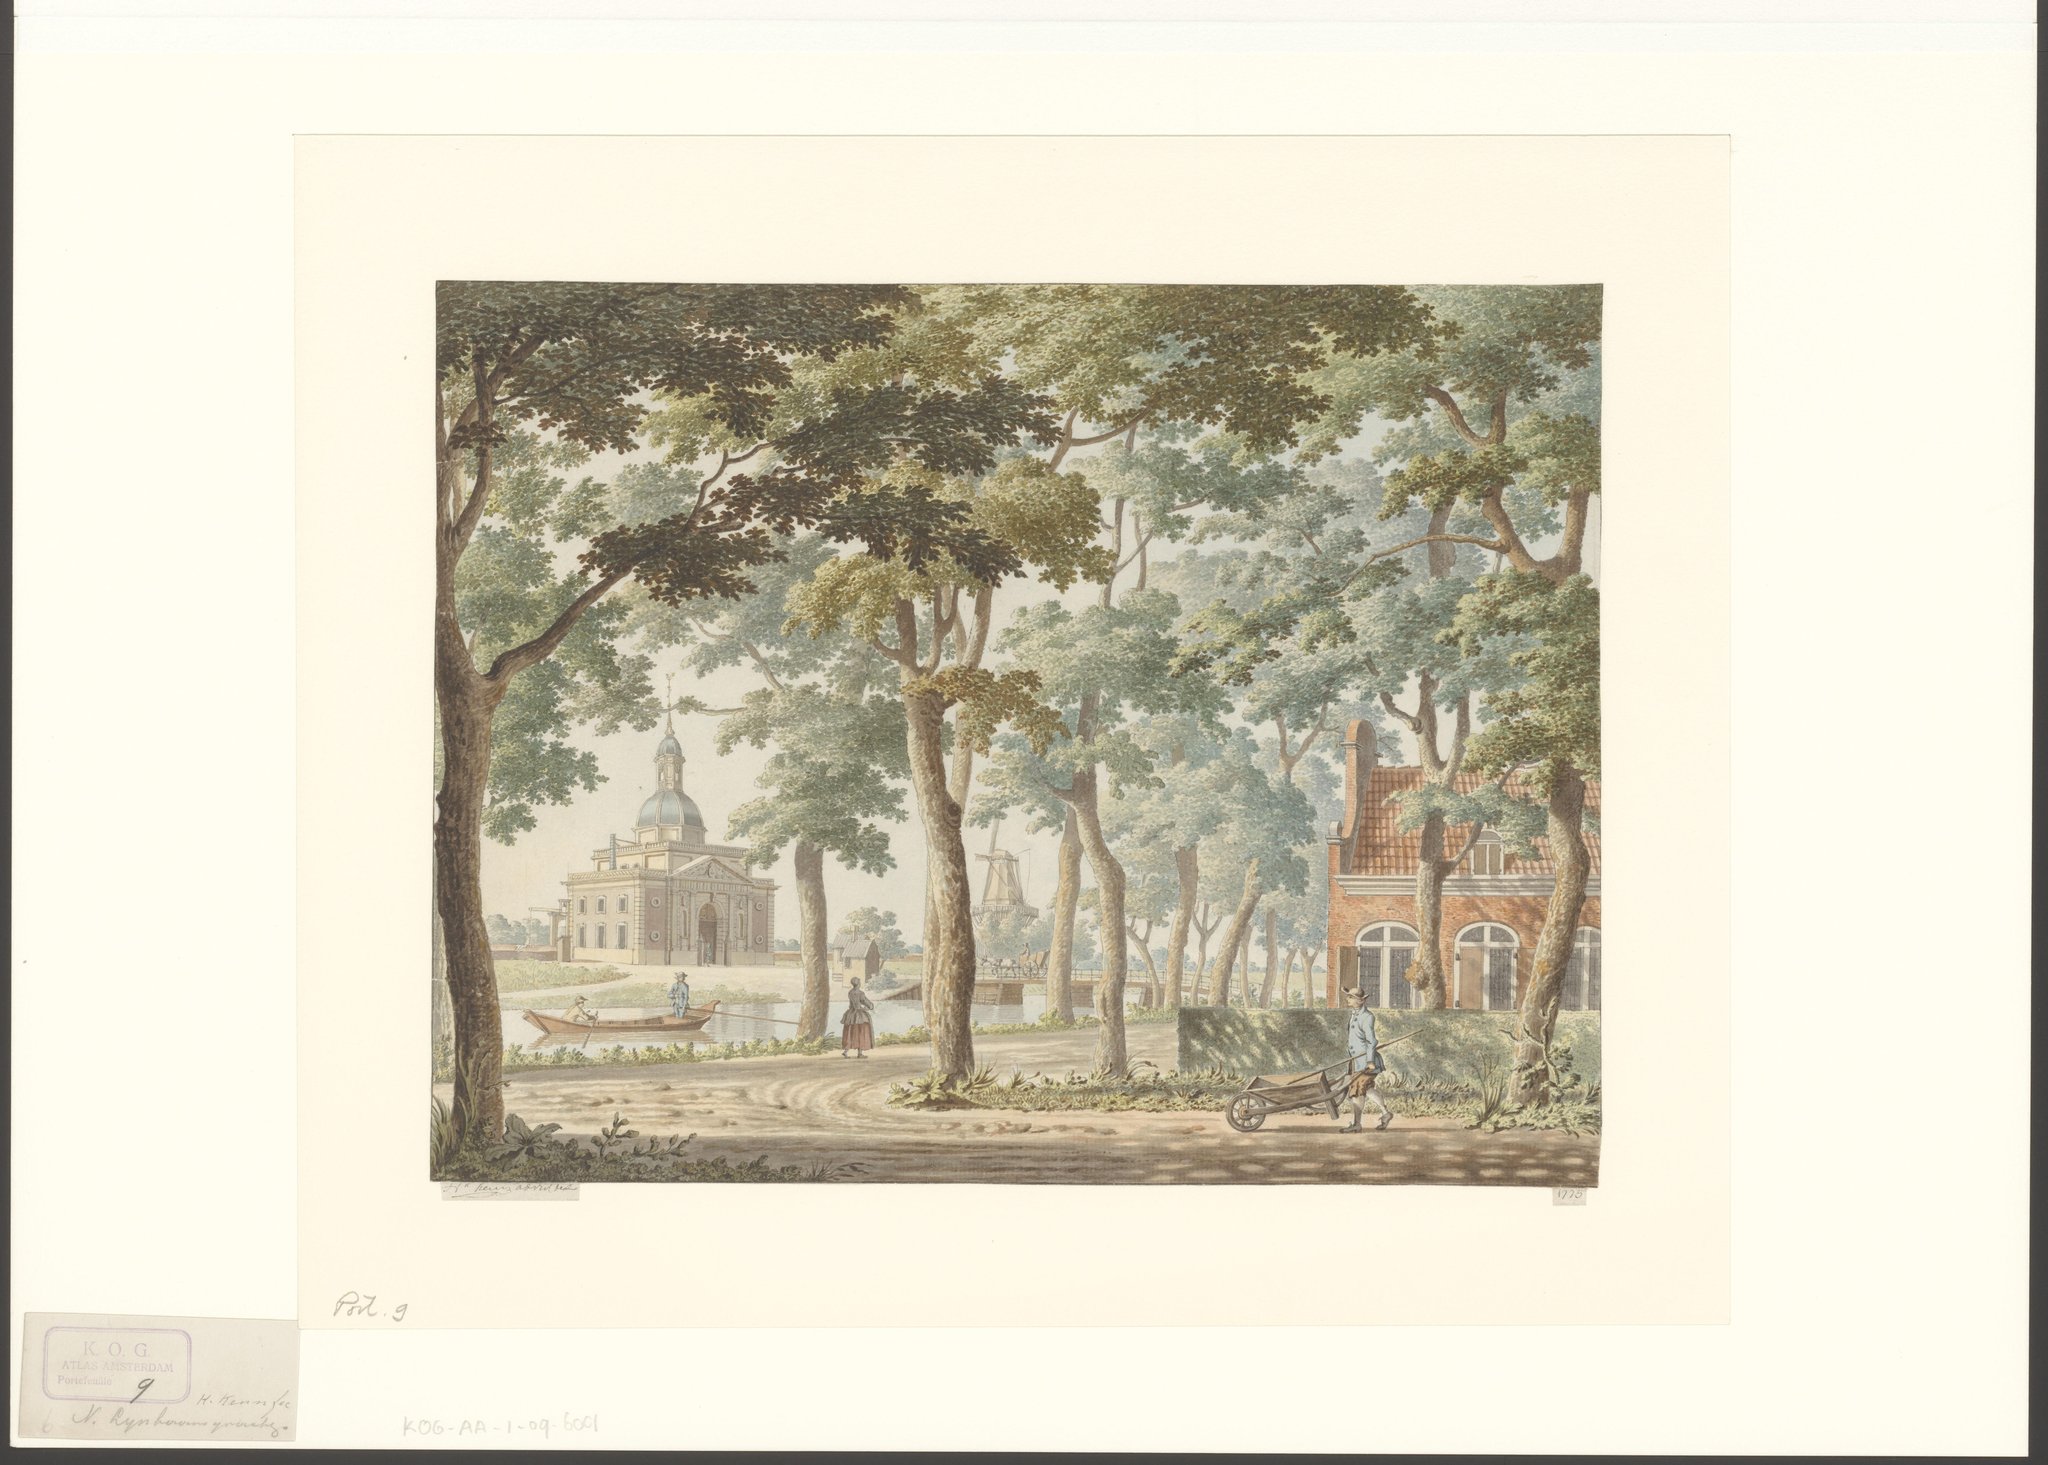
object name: drawing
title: Gezicht op de Muiderpoort over de Nieuwe Lijnbaansgracht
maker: hendrik keun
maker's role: painter, print maker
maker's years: 1738-1787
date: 1775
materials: ink, paper, pencil, watercolor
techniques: brush, pen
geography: amsterdam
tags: city-view in general; 'veduta', road, path, windmill in landscape, city-gate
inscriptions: signature and date: ‘Hk Keun adviv del / 1775’, inscription: ‘Port. 9’, collector's mark: ‘9’ Lugt 1641b, inscription: ‘H Keun fec /N. Lijnbaansgracht’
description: Onderwerpsrubriek binnen de Atlas Amsterdam: 2e Laurierdwarsstraat (Vuile Weespad), Leidschegracht, Leidschekade, Leidscheplein, Leidschestraat, v. Lennepkade, Lijnbaansgracht, Lauriergracht, Leliedwarsstraat, Leliegracht, Lindengracht, Lombardsteeg, Looiersgracht, Looiersstraat (Nieuwe), Leidekkerssteeg.